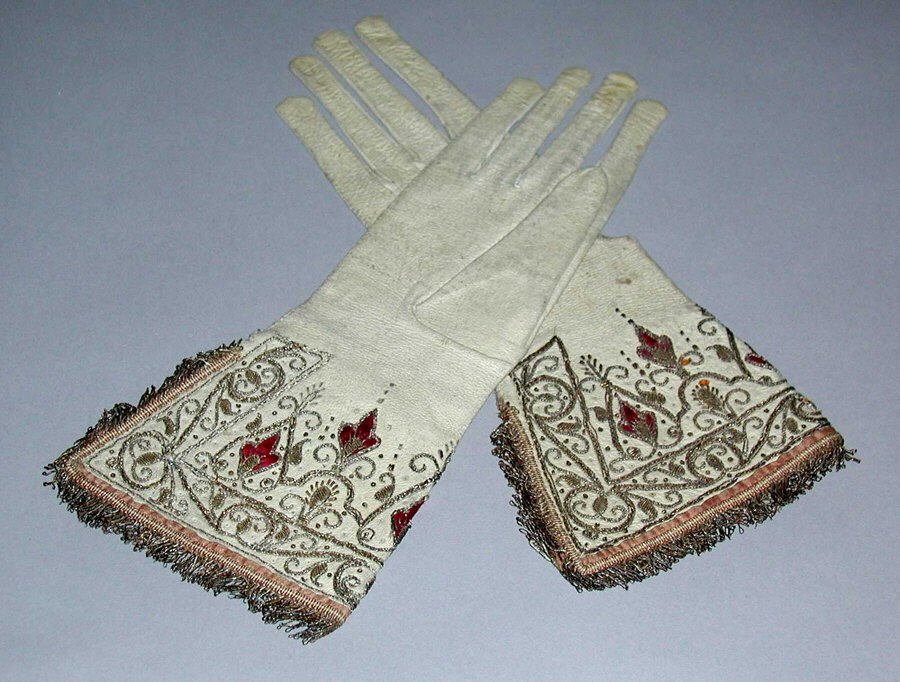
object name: glove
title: Gloves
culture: british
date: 1601-1700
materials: leather, metal thread